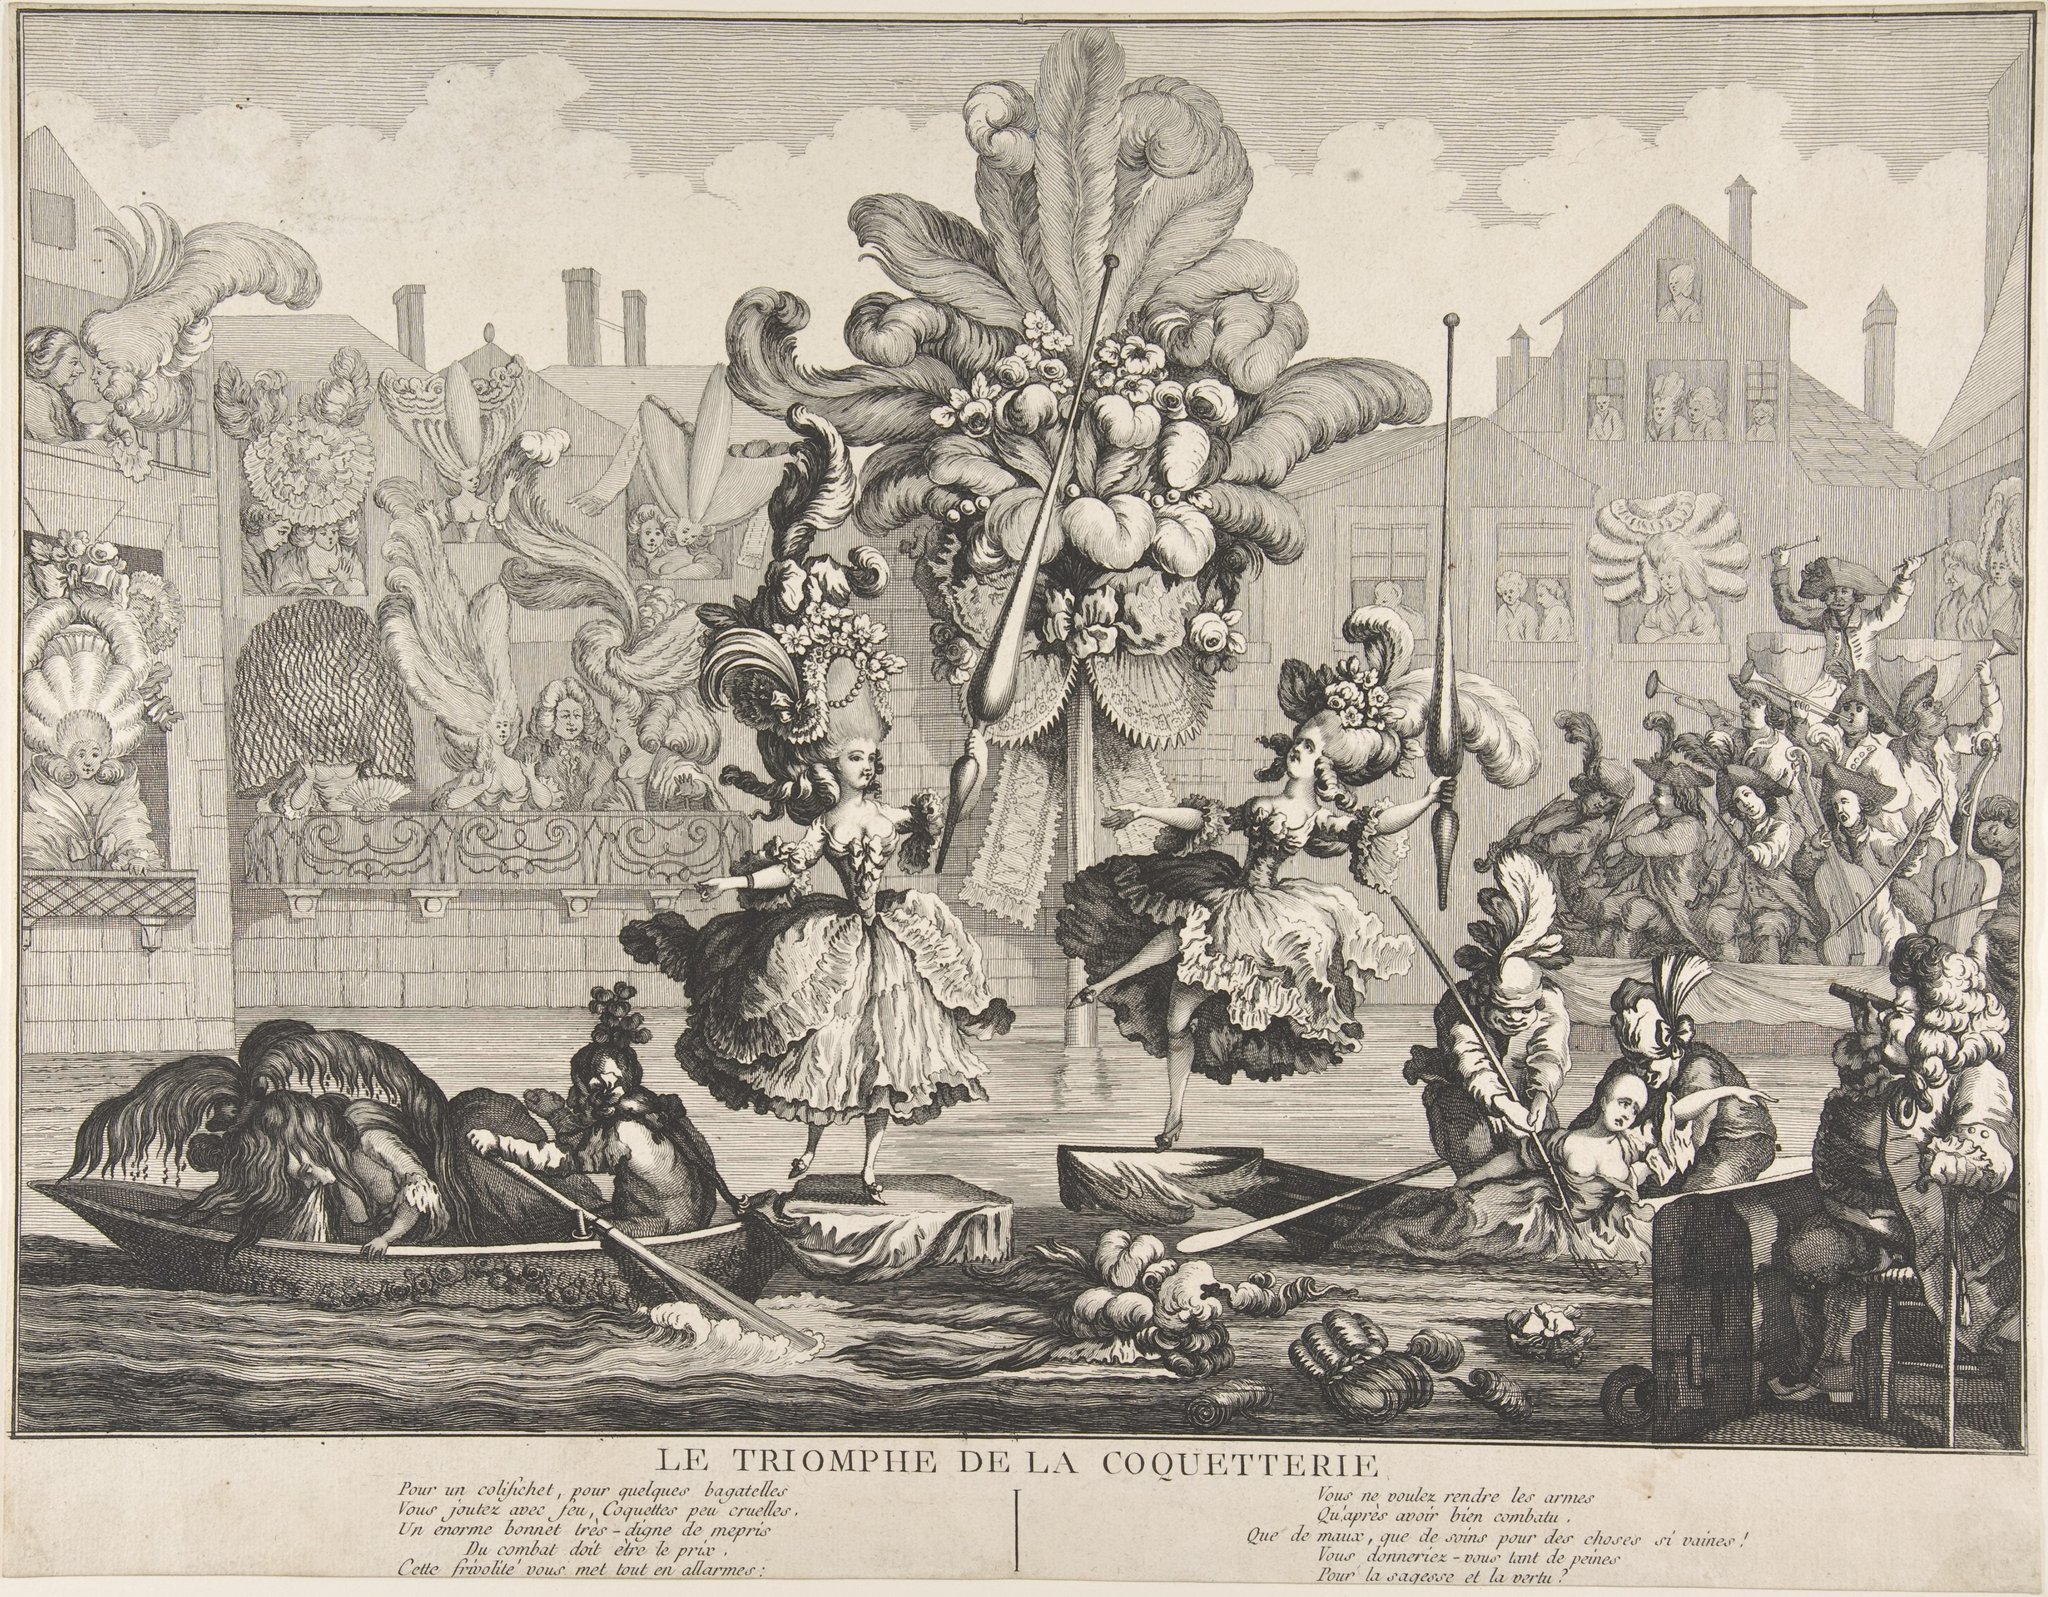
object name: print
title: Le triomphe de la coquetterie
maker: anonymous, french, 18th century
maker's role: artist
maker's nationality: french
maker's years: 1700-1800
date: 1701-1800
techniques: engraving, etching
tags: buildings,women,boats